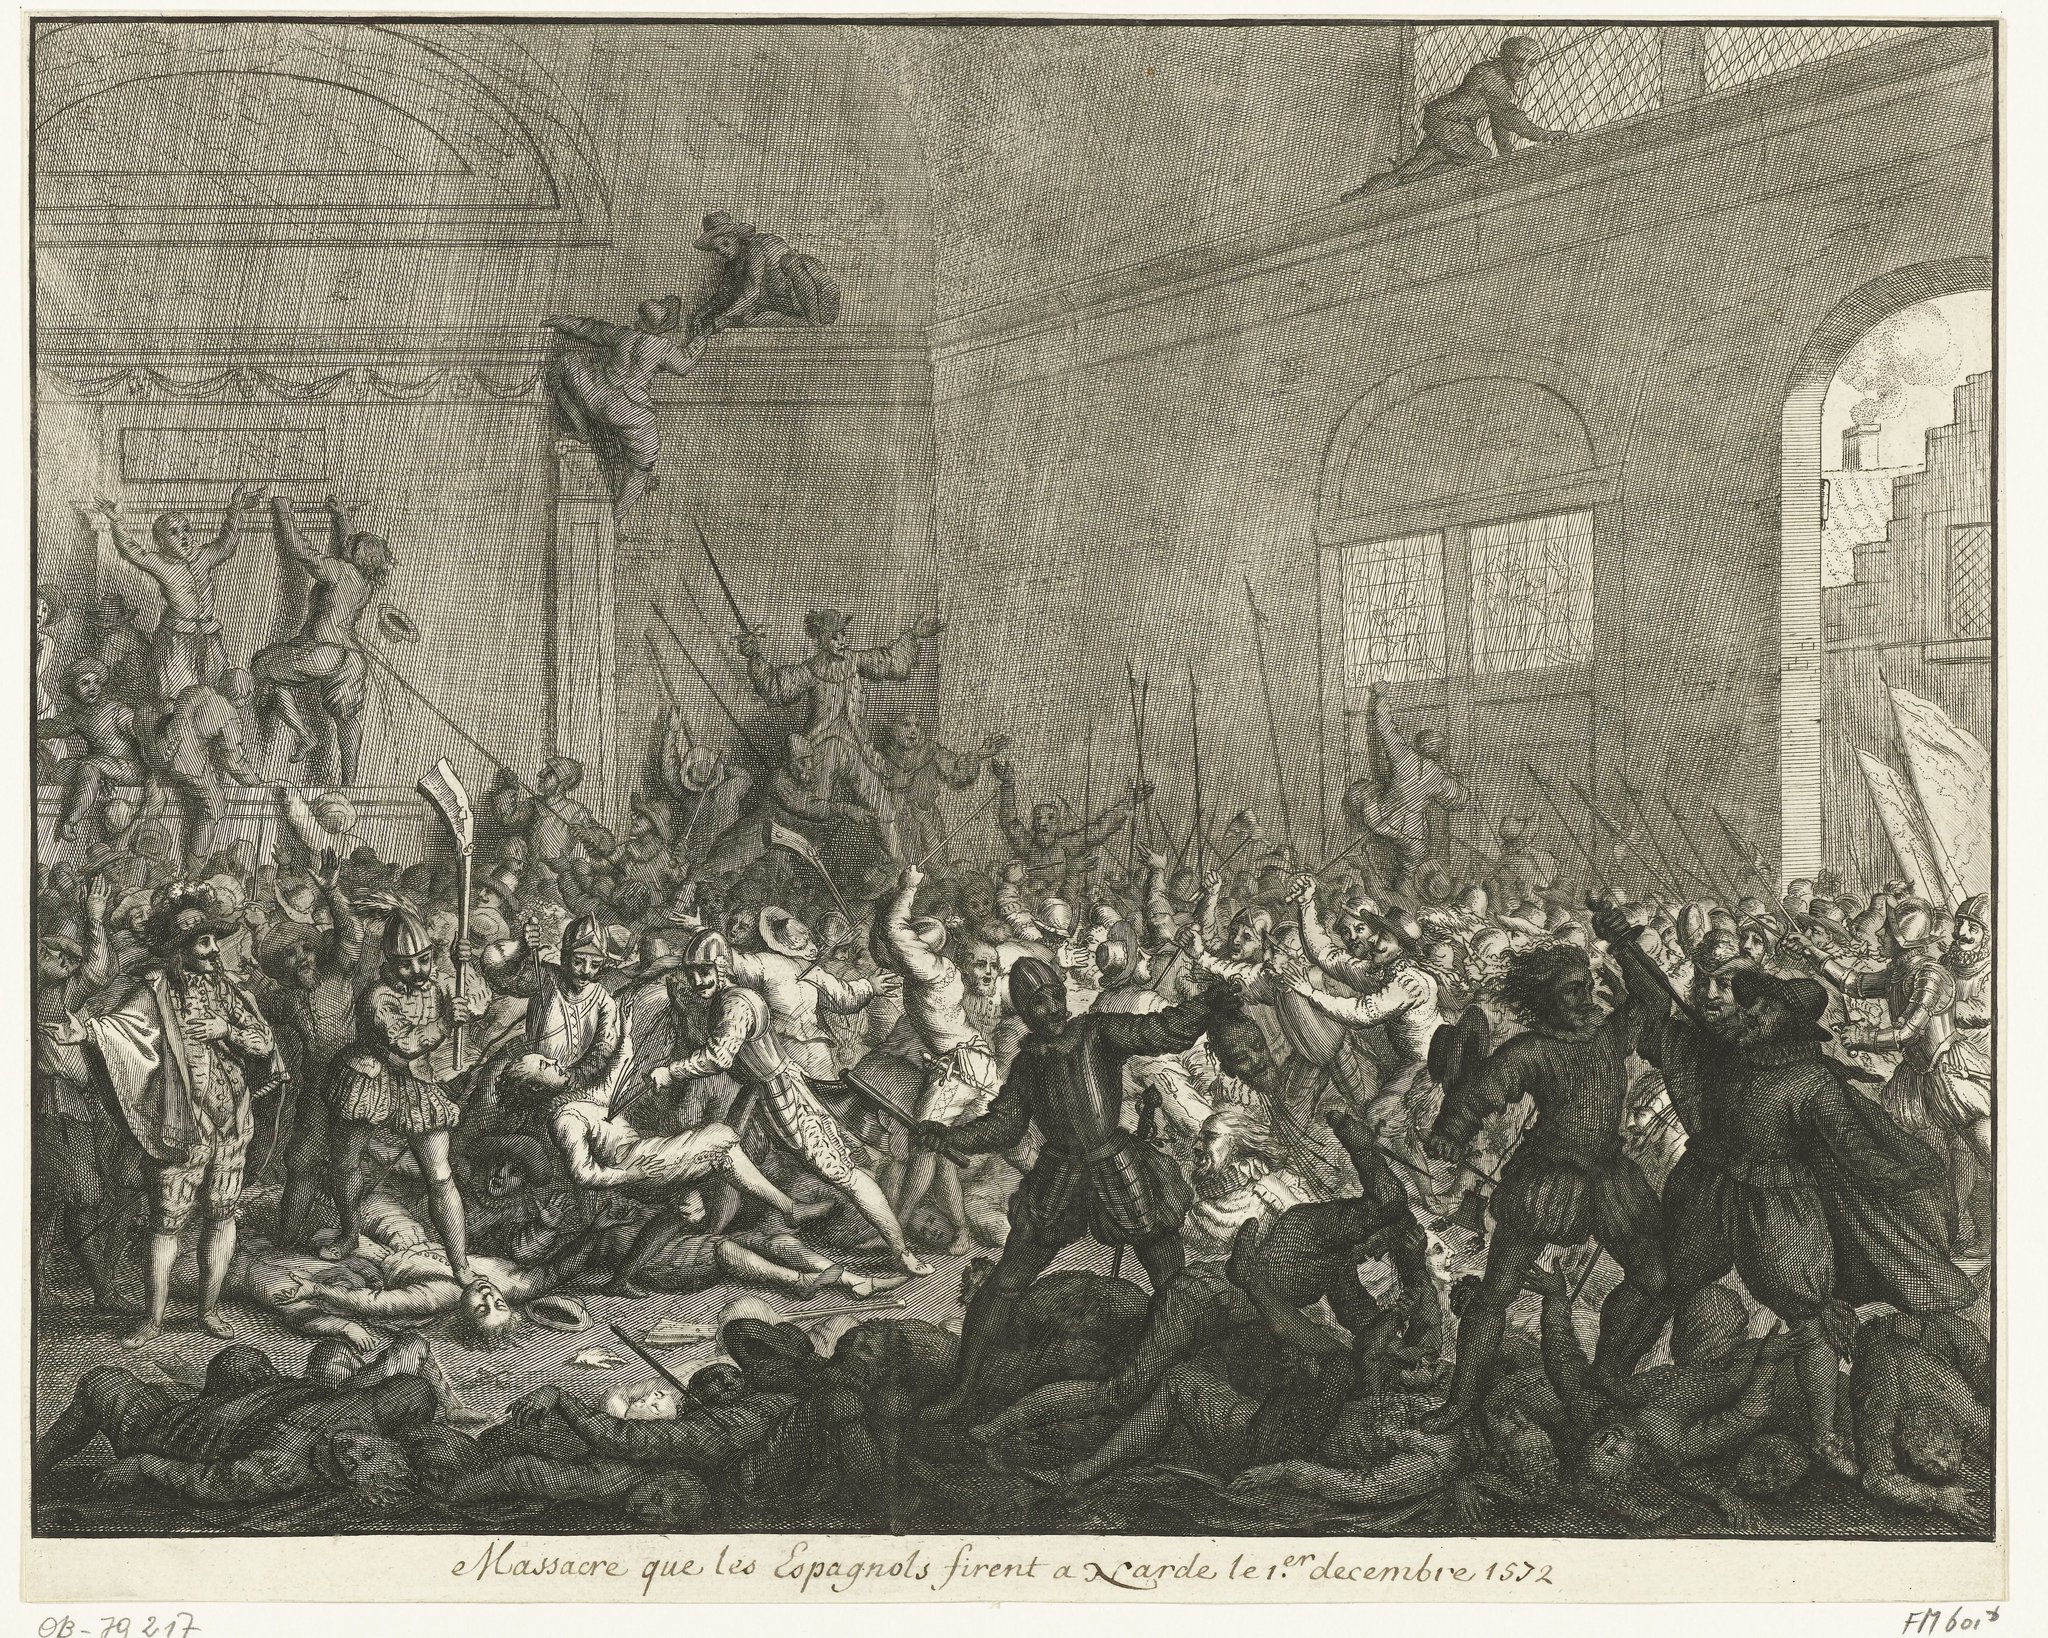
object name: history print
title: Moord in een kerk te Naarden, 1572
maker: jan luyken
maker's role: draughtsman, print maker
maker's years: 1649-1712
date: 1677-1679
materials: ink, paper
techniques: engraving, etching, pen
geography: amsterdam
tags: massacre ~ war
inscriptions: inscription: ‘Massacre que les Espagnols firent a Narde le 1.er decembre 1572’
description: Deze staat ter voorbereiding voor gebruik als illustratie in: J. le Clerc, Geschiedenissen der Vereenigde Nederlanden, sedert den aanvang van die Republyk tot op den Vrede van Utrecht in 't jaar 1713 en het Tractaat van Barriere in 't jaar 1715 gesloten, Z. Chatelain, Amsterdam 1730, 3 delen. Staat vóór de letter.